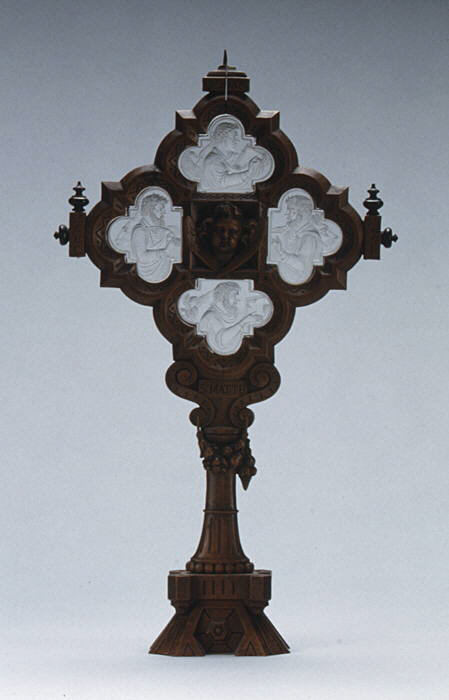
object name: plaque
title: The Four Evangelists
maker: valerio belli (il vicentino)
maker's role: maker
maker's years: 1468-1546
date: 1501-1600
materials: wood, quartz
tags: faces,men